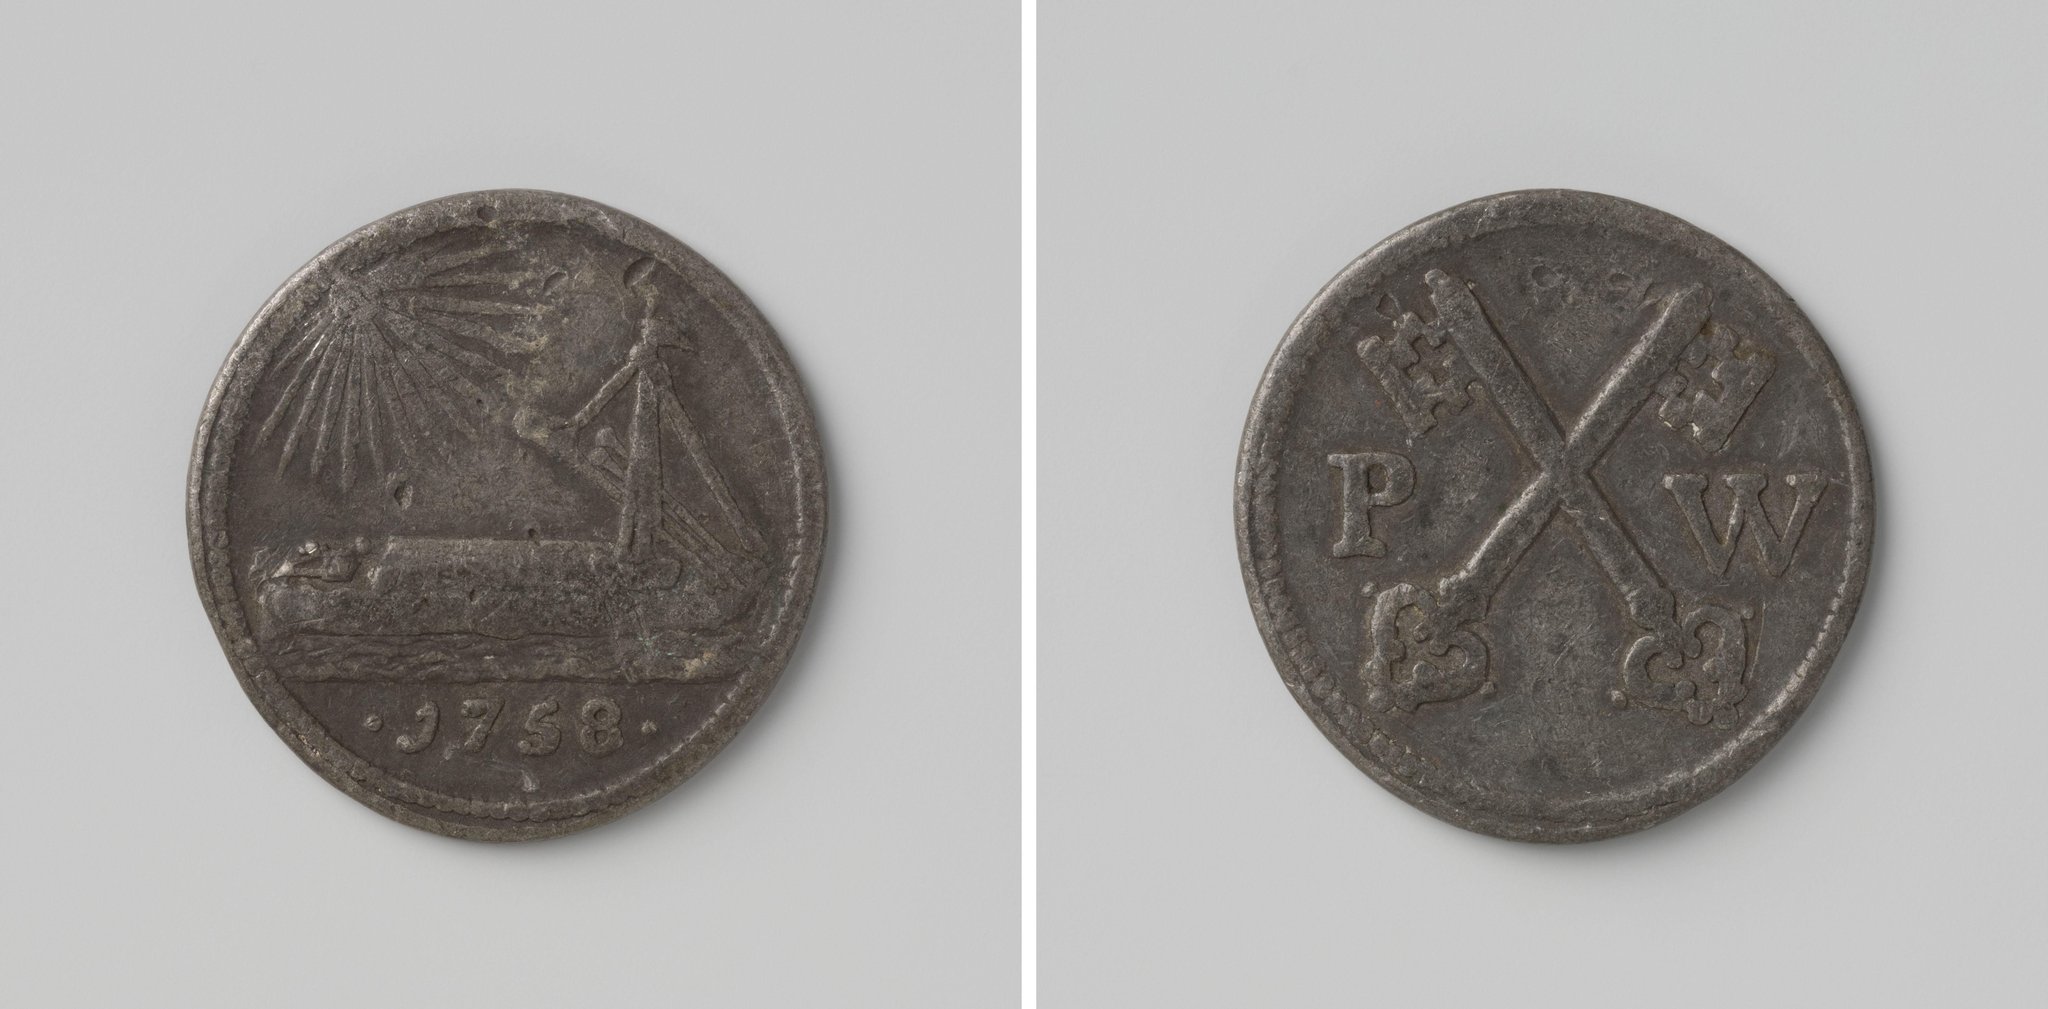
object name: armenloodje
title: Waalse gemeente van Leiden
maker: Anonymous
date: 1758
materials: lead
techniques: striking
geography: leiden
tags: leiden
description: Loden penning. Voorzijde: naar rechts varend schip, beschenen door zon; afsnede: jaartal. Keerzijde: twee gekruiste sleutels tussen letters P en W